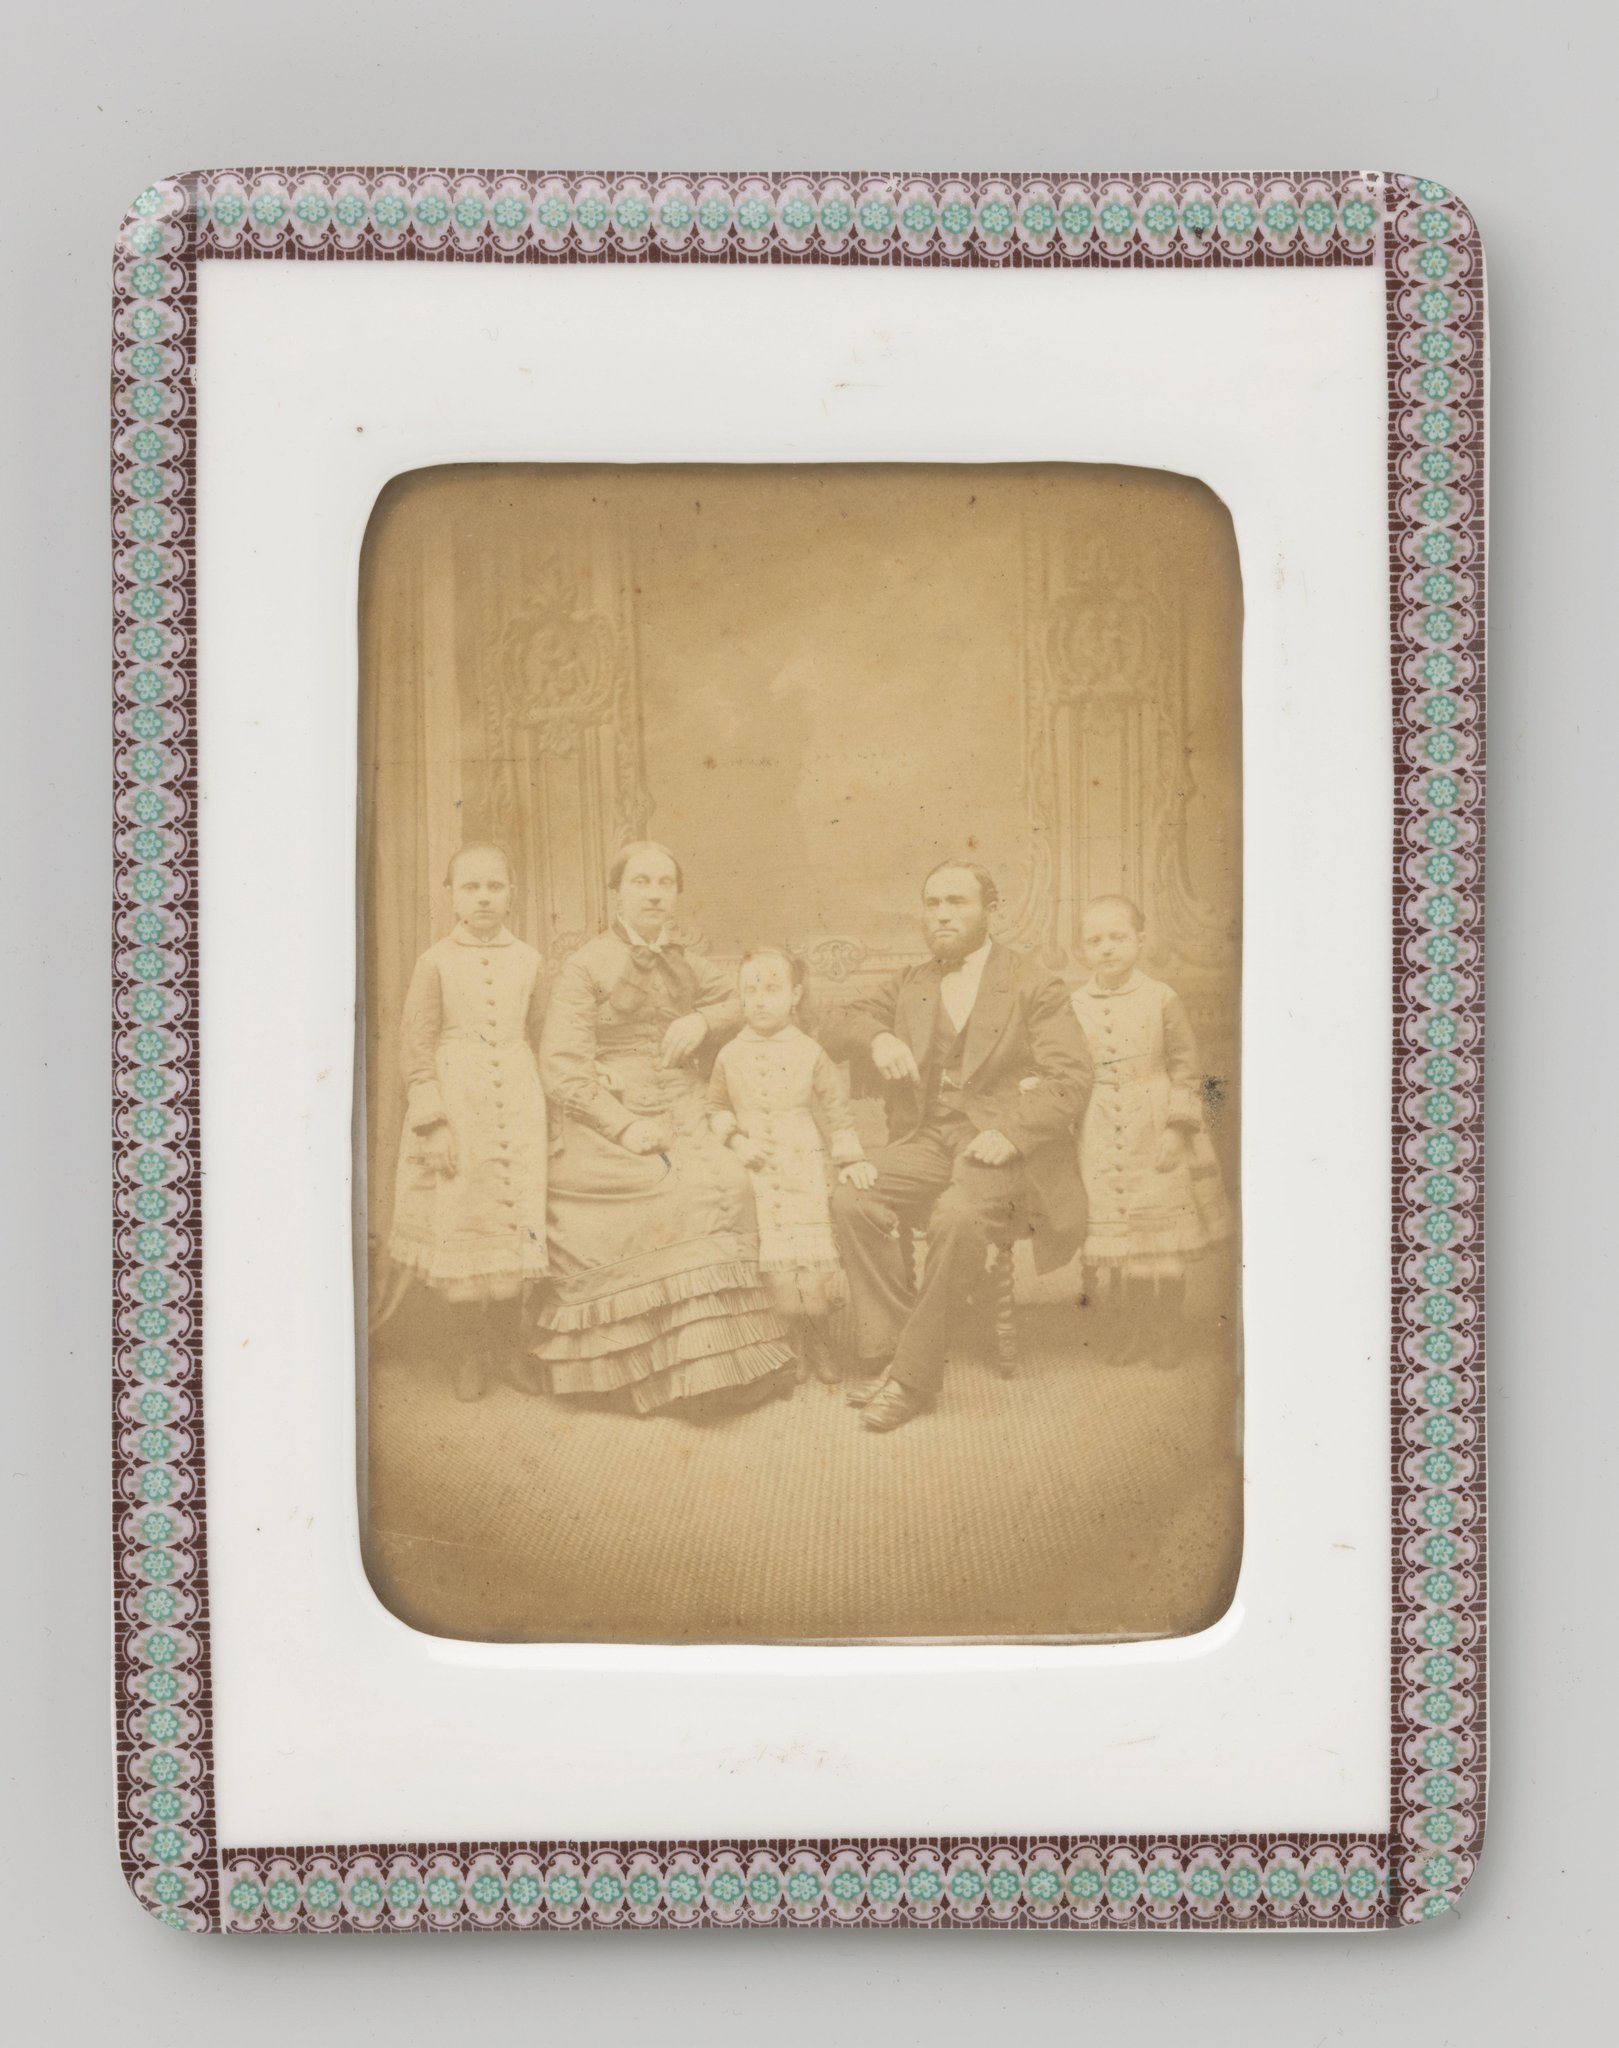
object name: frame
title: Groepsportret van een onbekende familie met drie kinderen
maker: Anonymous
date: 1880-1900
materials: cardboard, ceramic, glass, metal, paper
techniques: albumen print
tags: family life, anonymous historical person portrayed